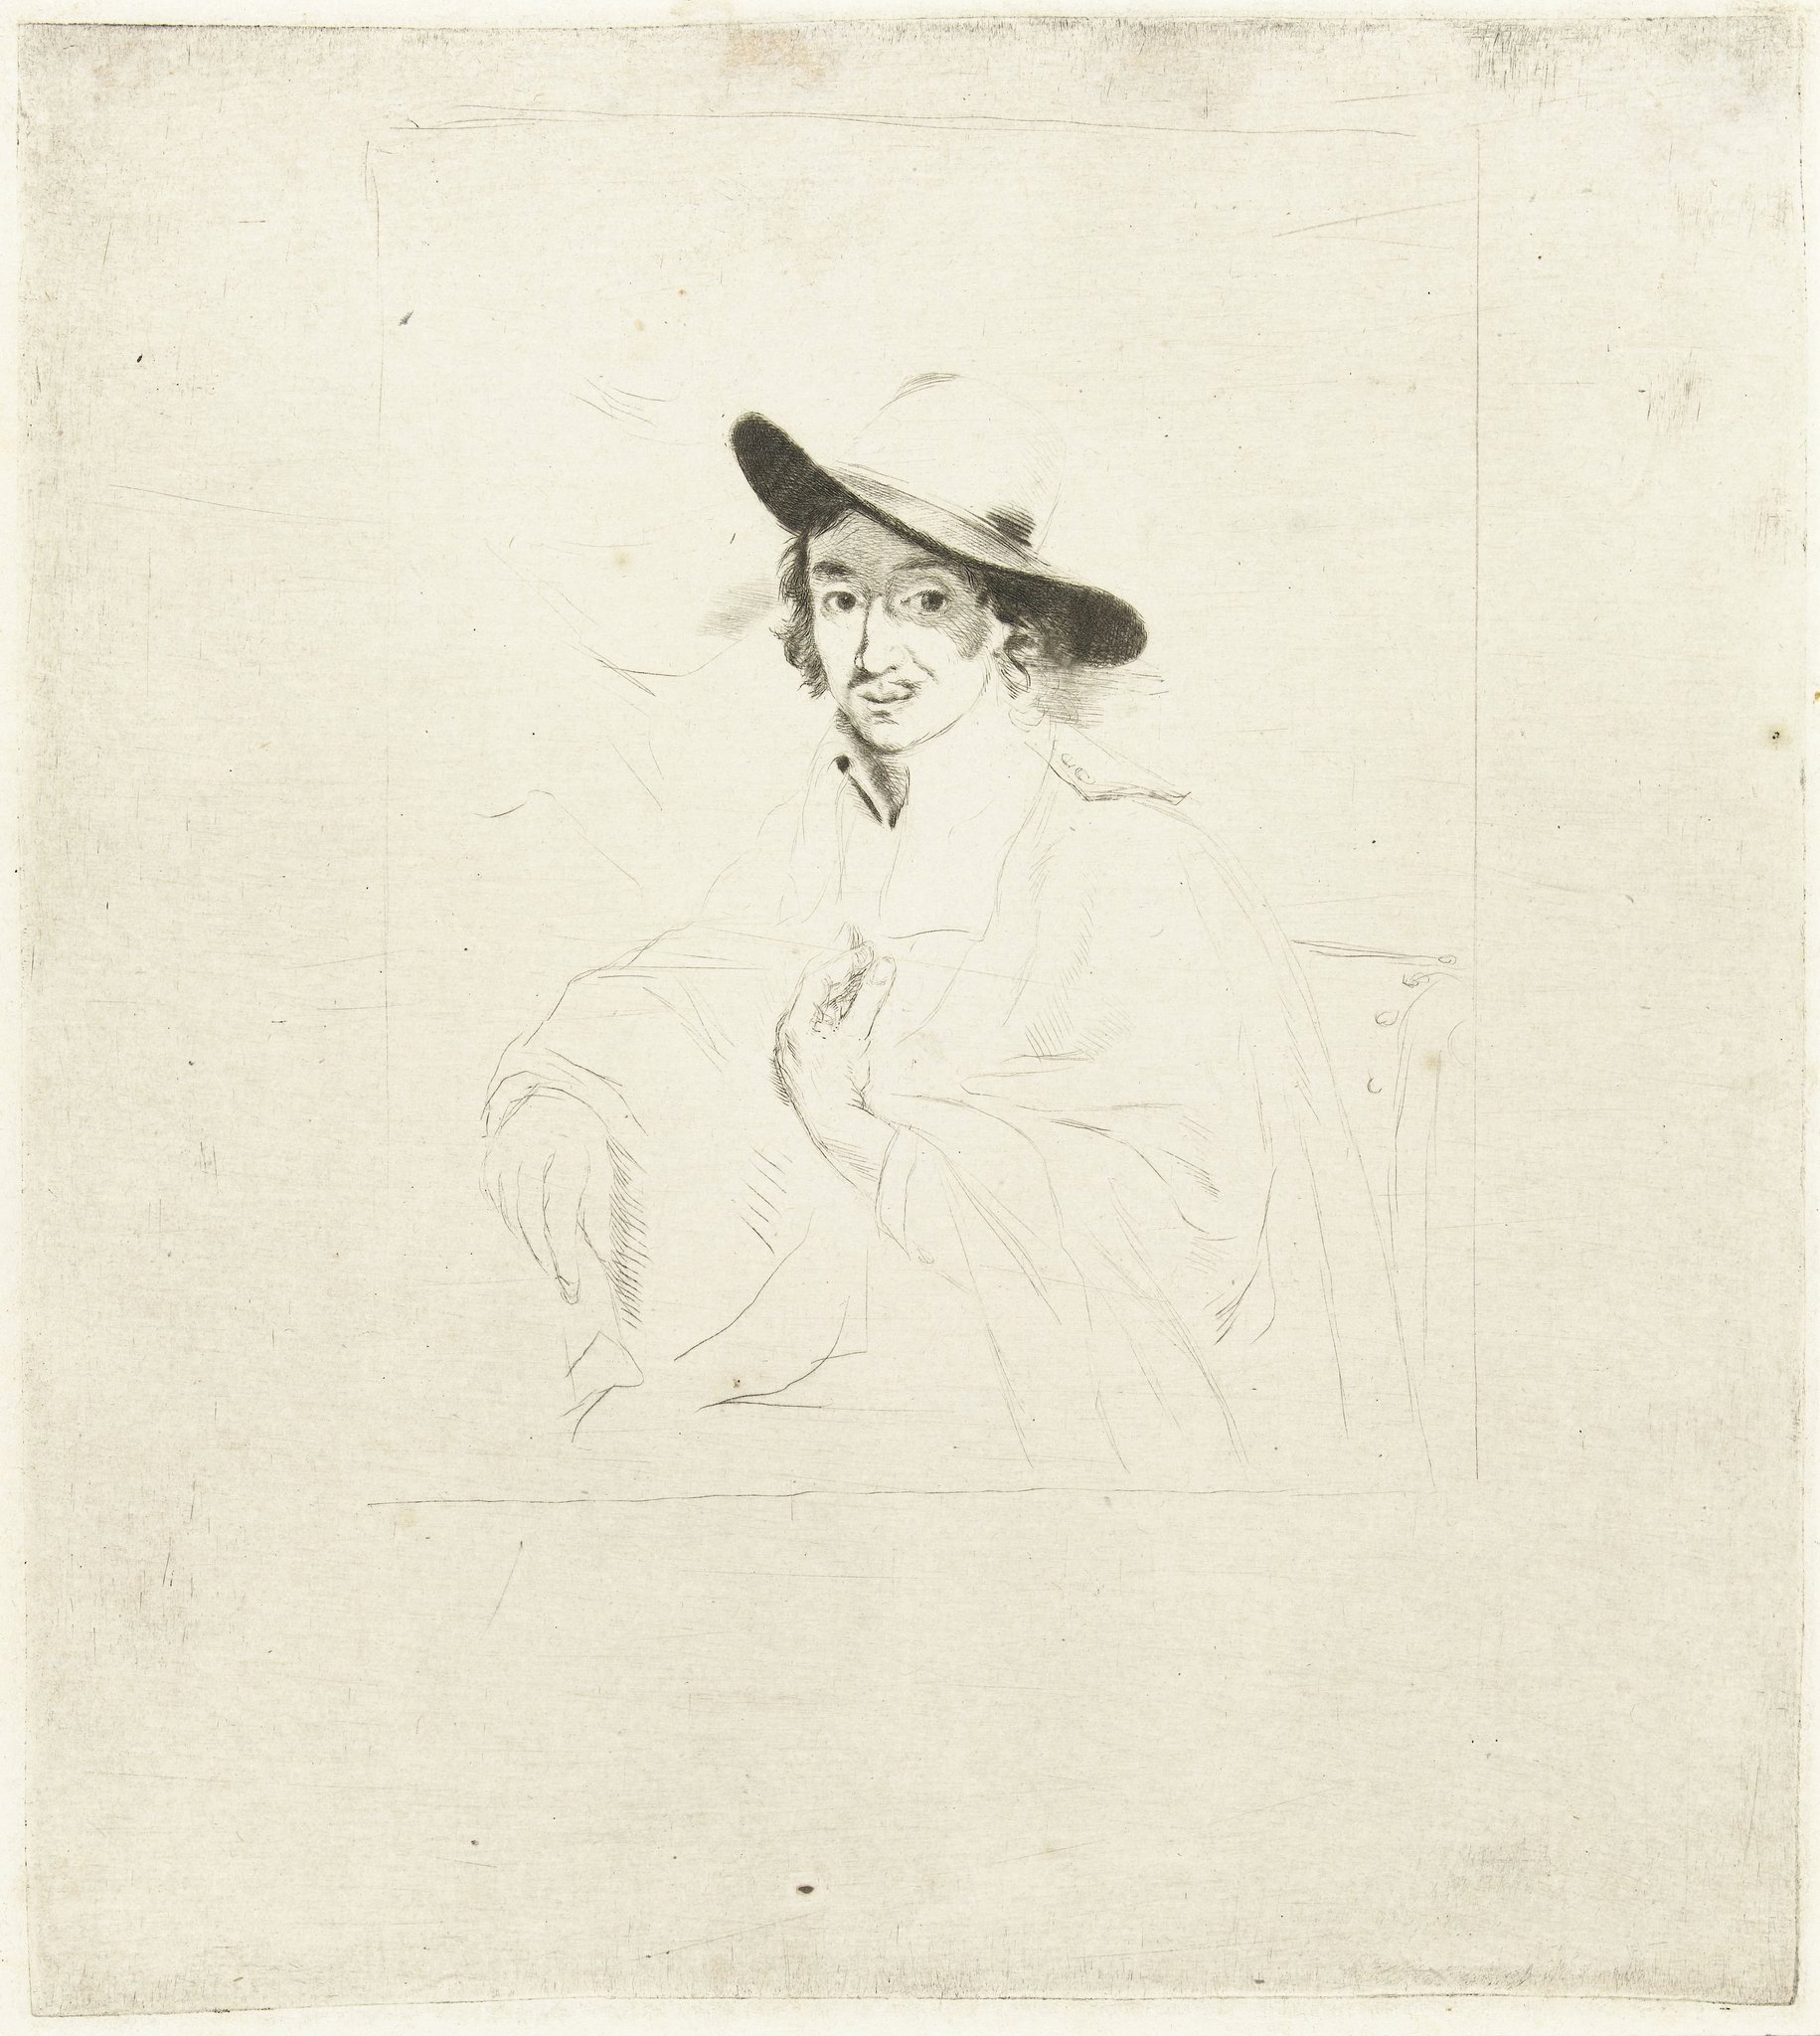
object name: print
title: Portret van de schilder Adriaen van Ostade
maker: louis bernard coclers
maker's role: draughtsman, print maker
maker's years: 1741-1817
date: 1756-1817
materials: paper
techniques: drypoint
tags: haarlem, painter, draughtsman, adriaen van ostade, portrait, self-portrait of artist (+ artist in non-work situation)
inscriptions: collector's mark: Lugt 2228